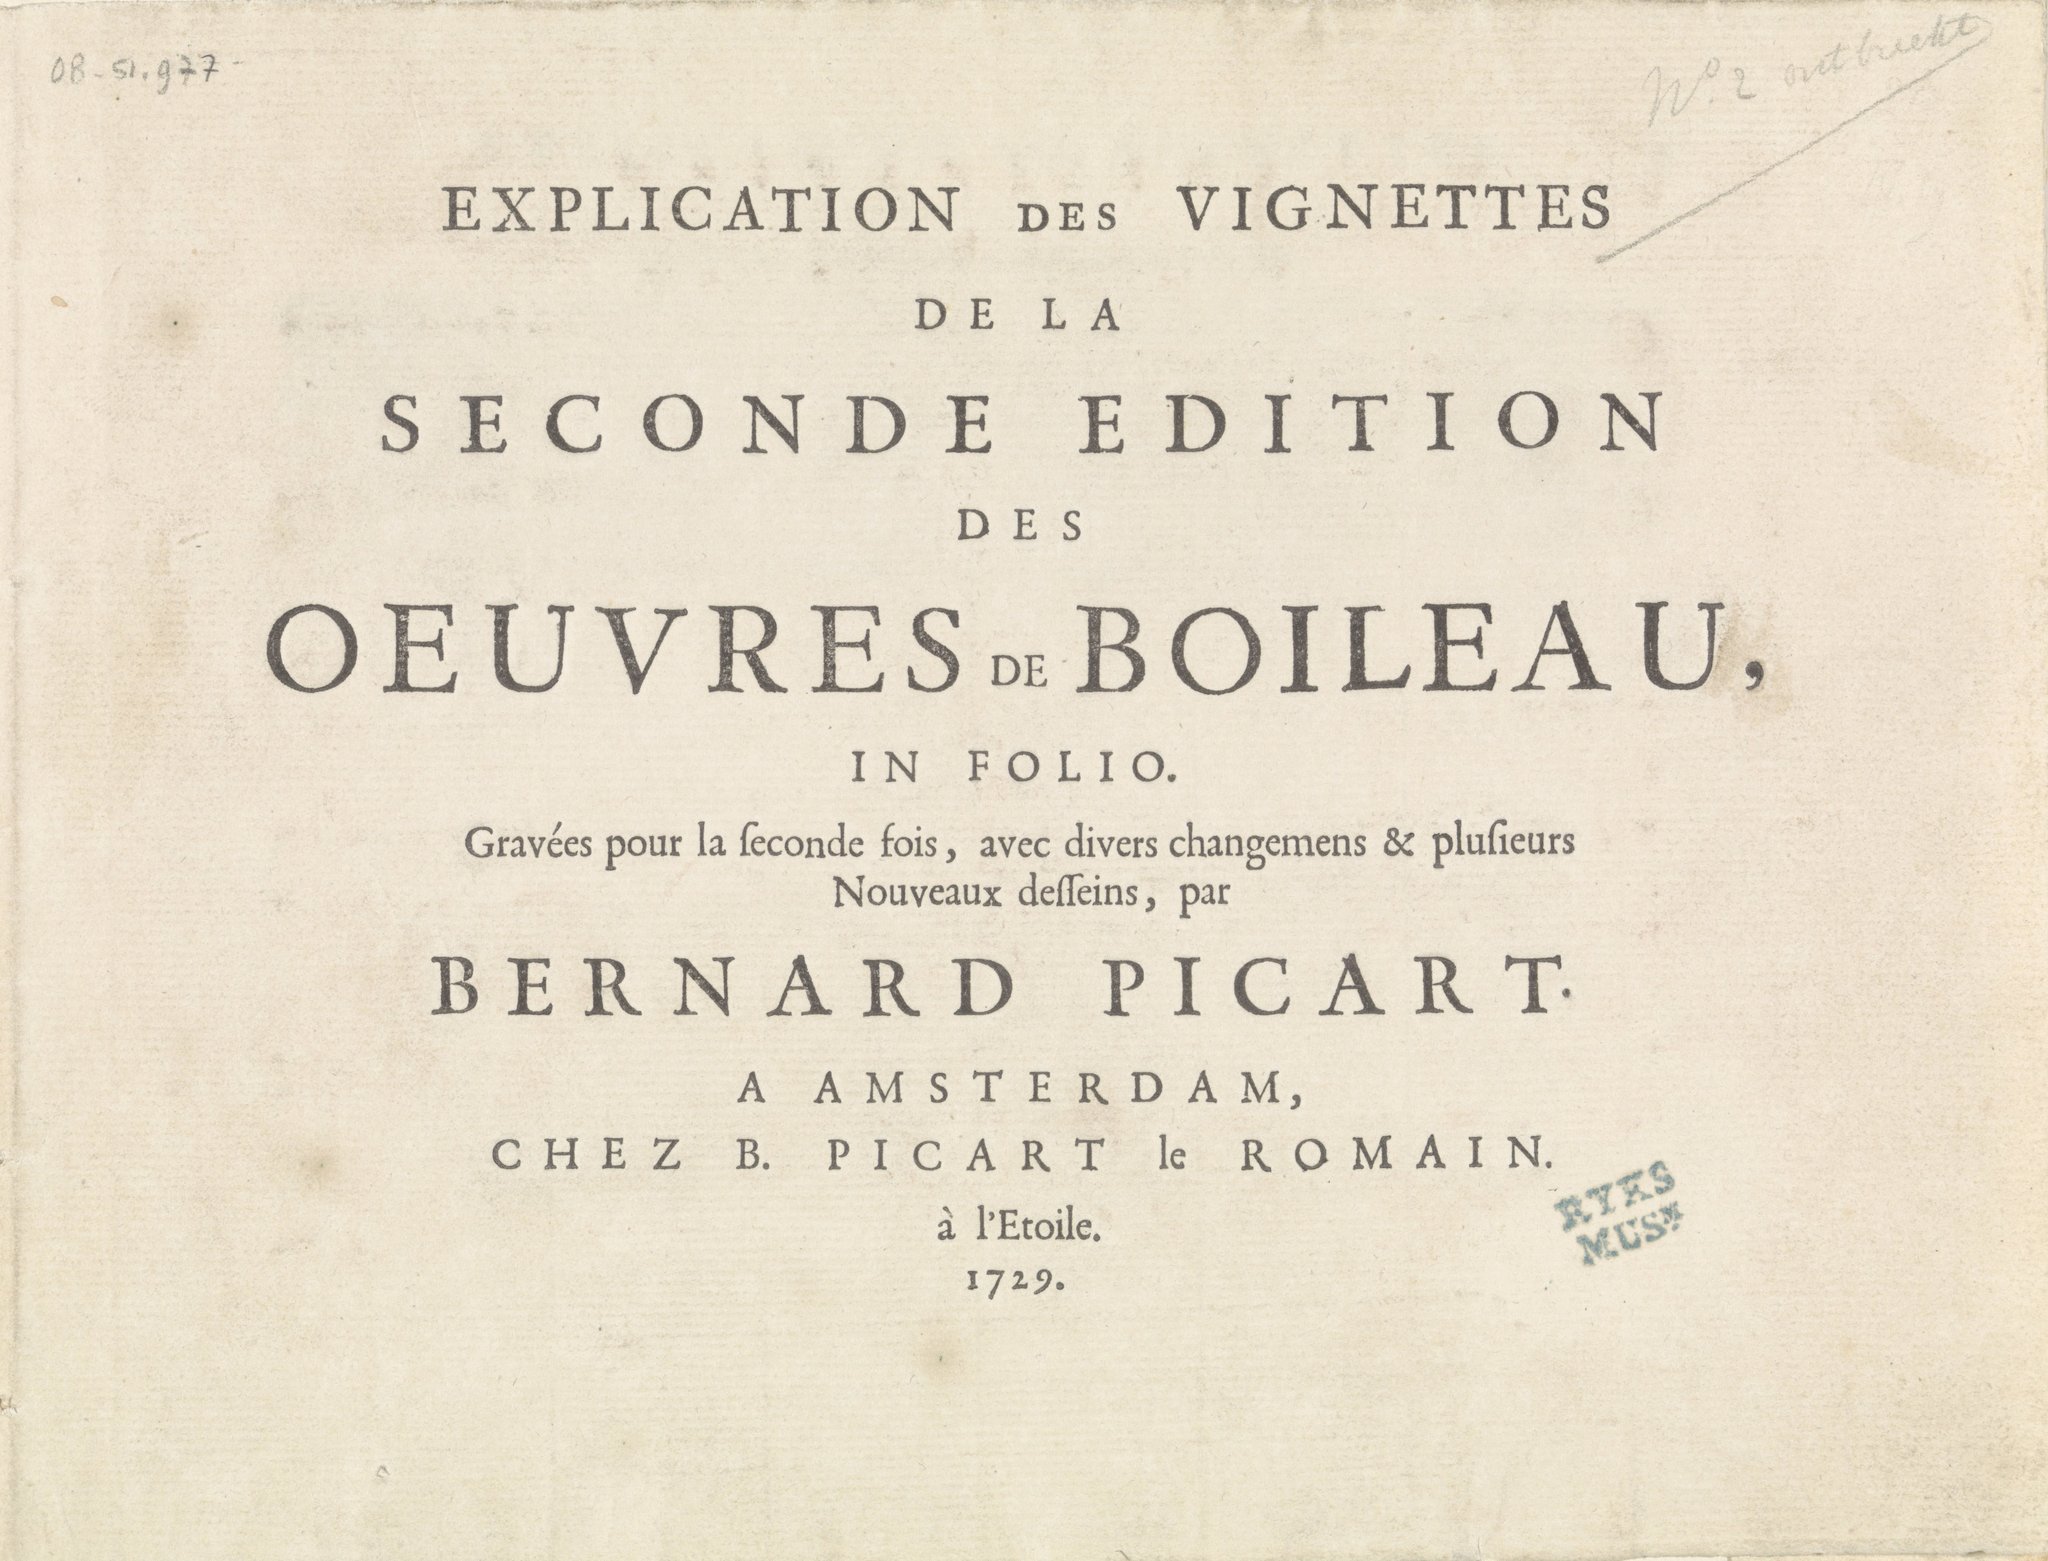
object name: book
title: Explication des Vignettes de la Seconde Edition des Oeuvres de Boileau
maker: bernard picart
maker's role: draughtsman, print maker, publisher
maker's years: 1673-1733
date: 1729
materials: paper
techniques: letterpress printing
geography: amsterdam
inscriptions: inscription: ‘Les (...) pour les Boileau en 2 pieces, graves pour (...)NB. manqúe No 2.’, collector's mark: Lugt 2165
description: Boekje van acht pagina's (bestaande uit twee gevouwen tekstbladen) met toelichtingen in het Frans op de prenten van Bernard Picart in de tweede editie van Oeuvres van Boileau. Het boekje bevat een met de hand beschreven blad papier.